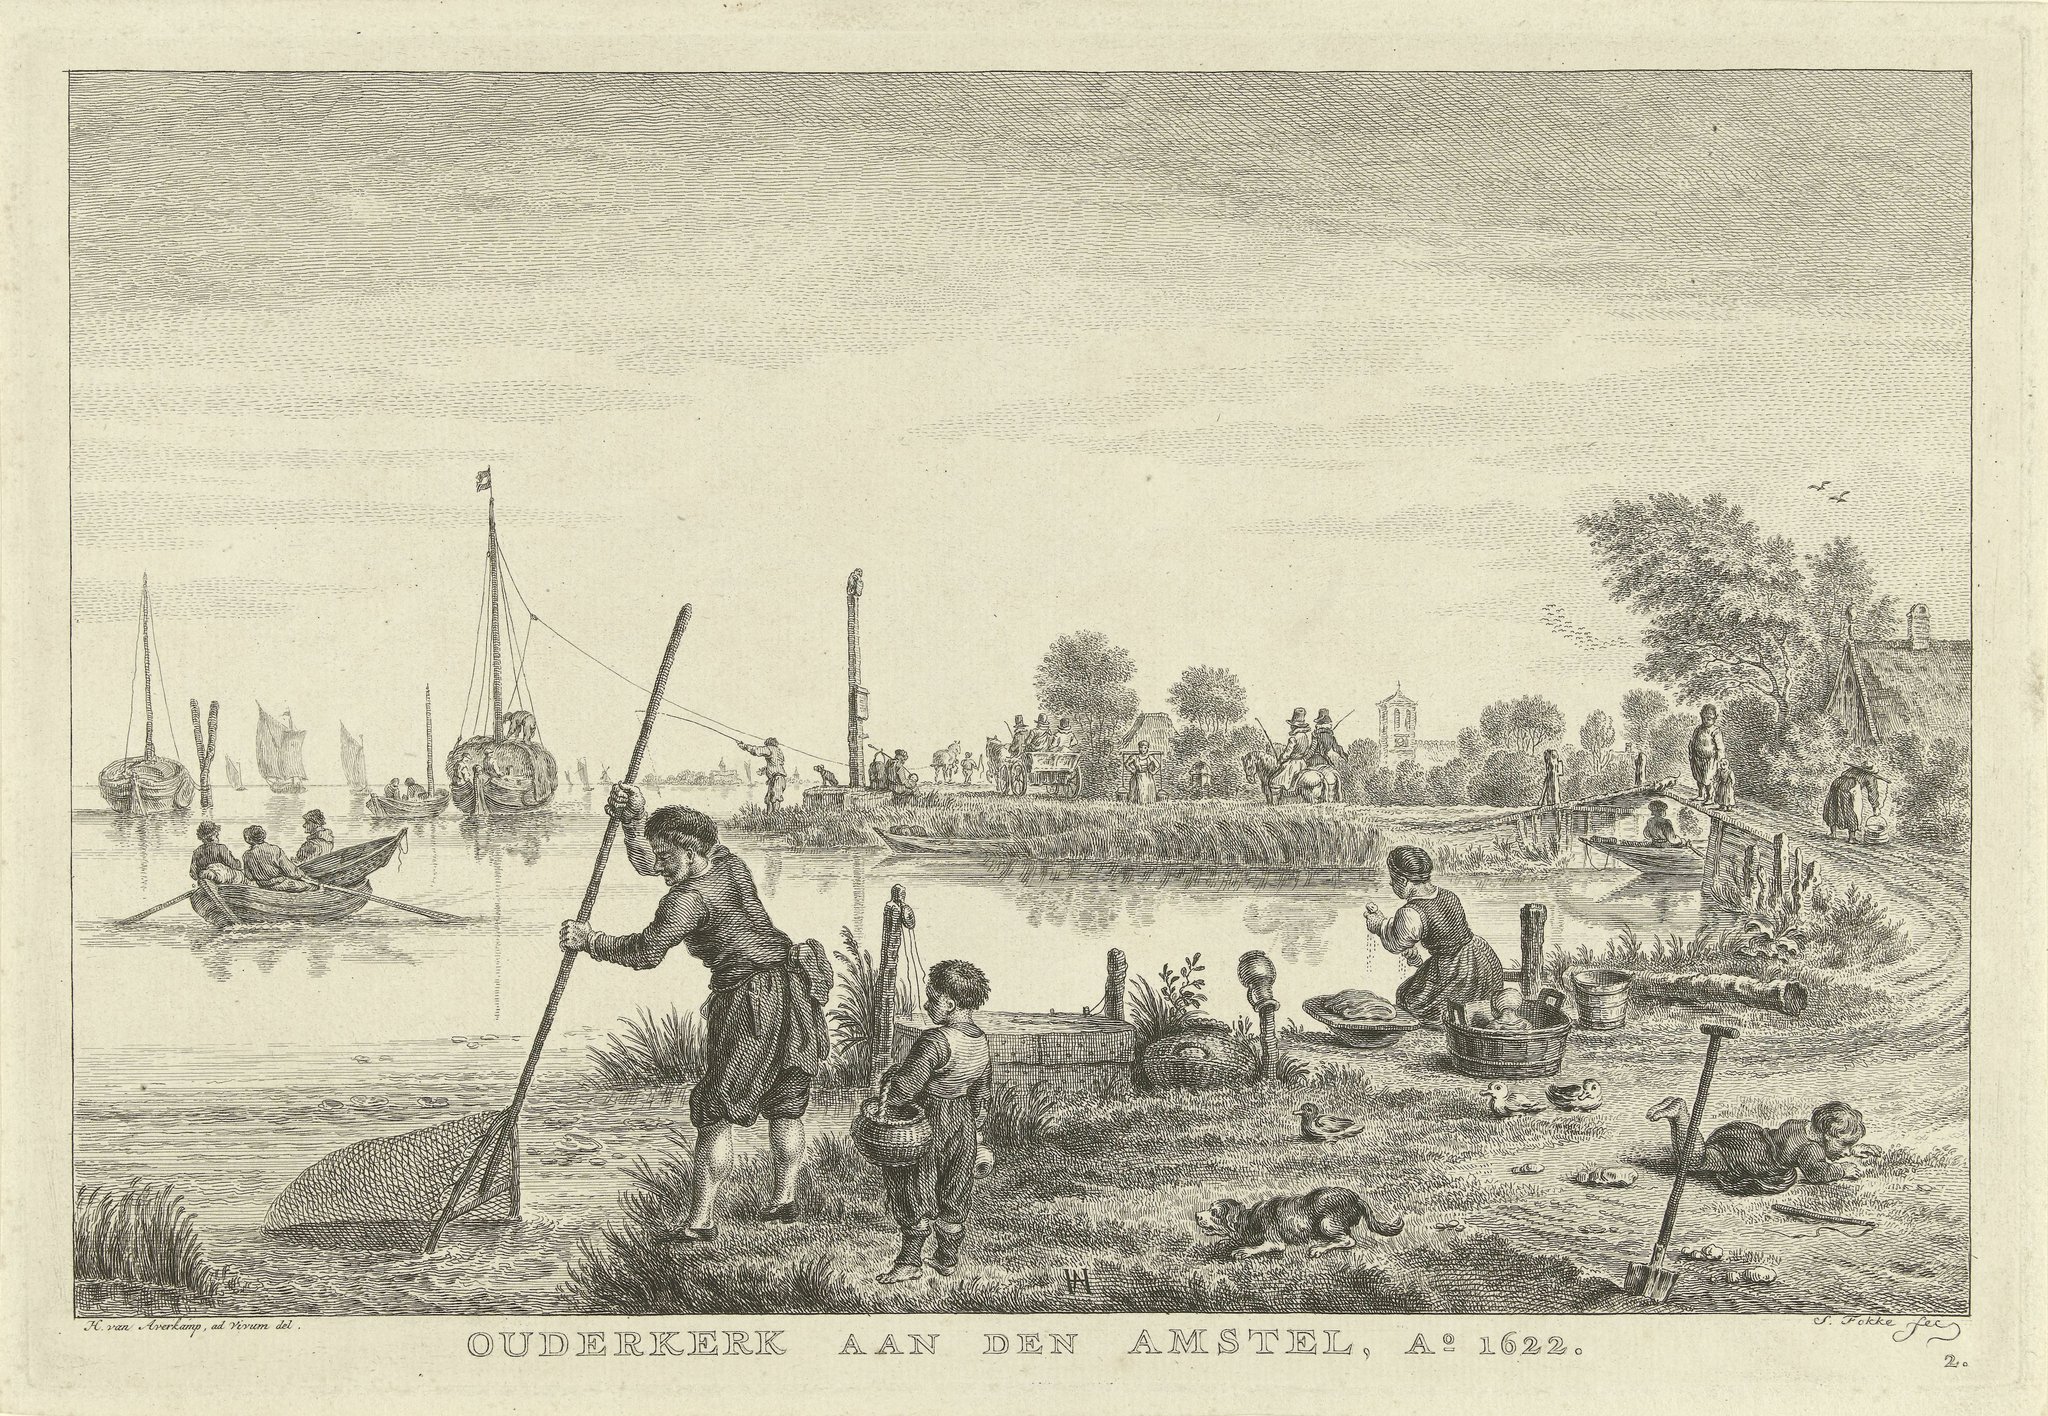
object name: print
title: Figuren op de oever bij Ouderkerk aan de Amstel, 1622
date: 1722-1784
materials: paper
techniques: etching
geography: amsterdam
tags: river bank, rowing-boat, canoe, etc., open-air recreation, fisherman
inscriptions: collector's mark: Lugt 2228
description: Figuren op de oever bij Ouderkerk aan de Amstel. Een jongetje kijkt toe hoe een man met een schepnet vis vangt. De vrouw verderop doet de was en heeft haar kind in de wastobbe achter haar gezet. In het gras van de oever liggen eenden, een hond en een spelend kind. In de verte passanten te voet en te paard. Op het water varen roei- en zeilschepen.